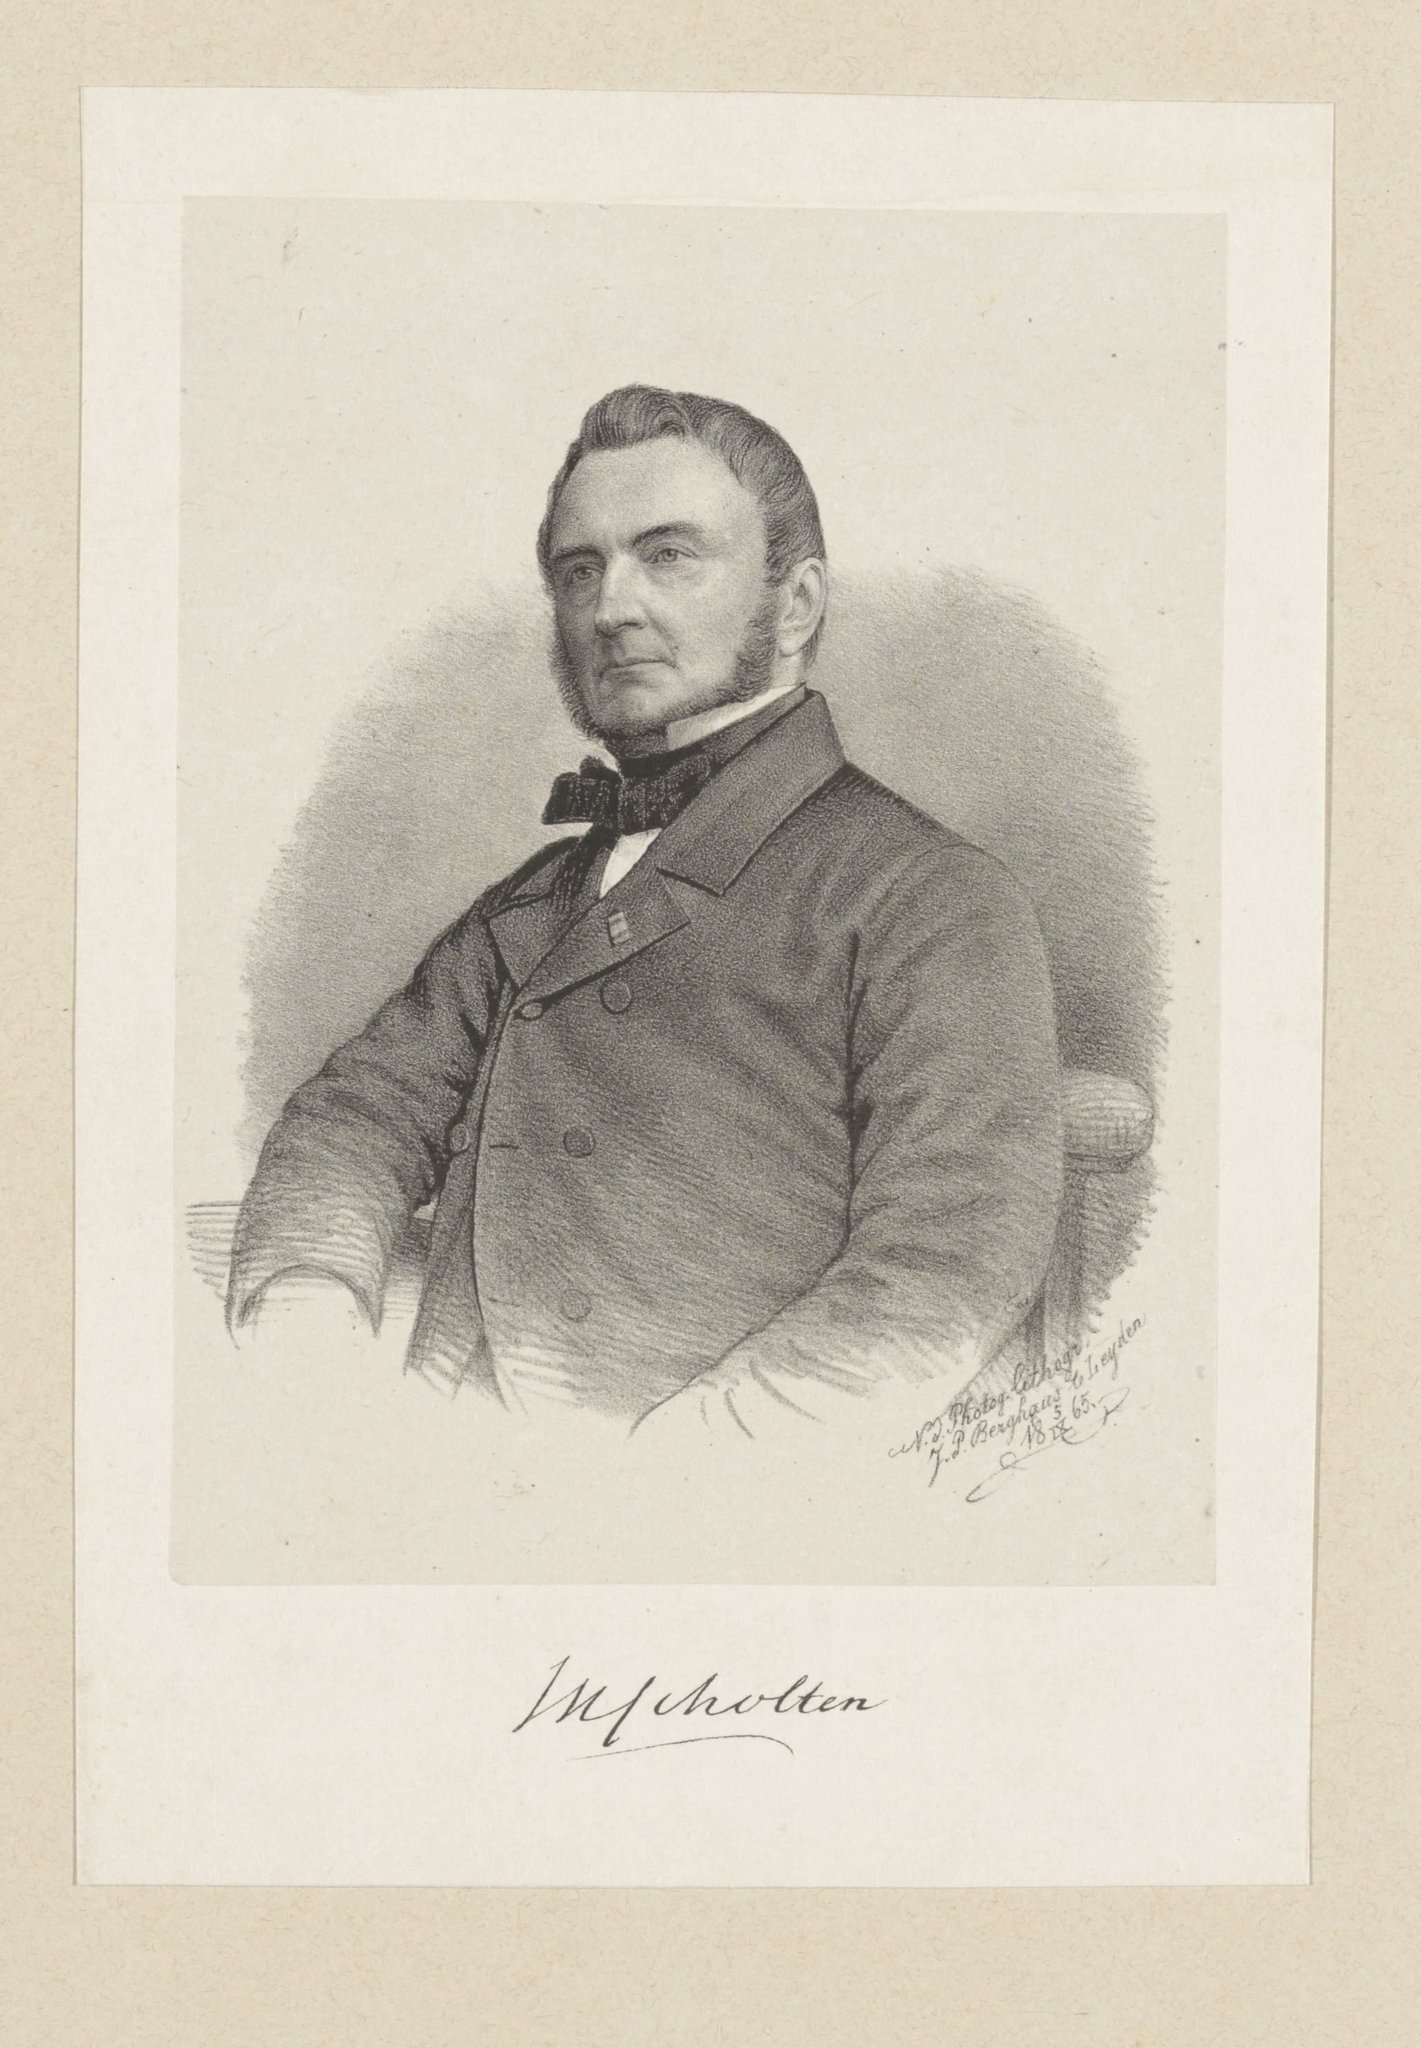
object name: print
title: Portret van Johannes Henricus Scholten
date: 1865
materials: paper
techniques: lithograph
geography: leiden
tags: vleuten, knighthood order, historical persons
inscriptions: collector's mark: Lugt 2228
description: De geportretteerde zit op een stoel en leunt met zijn rechterarm op een tafel. Hij draagt een strik en een ridderorde. Onder het portret zijn signatuur.